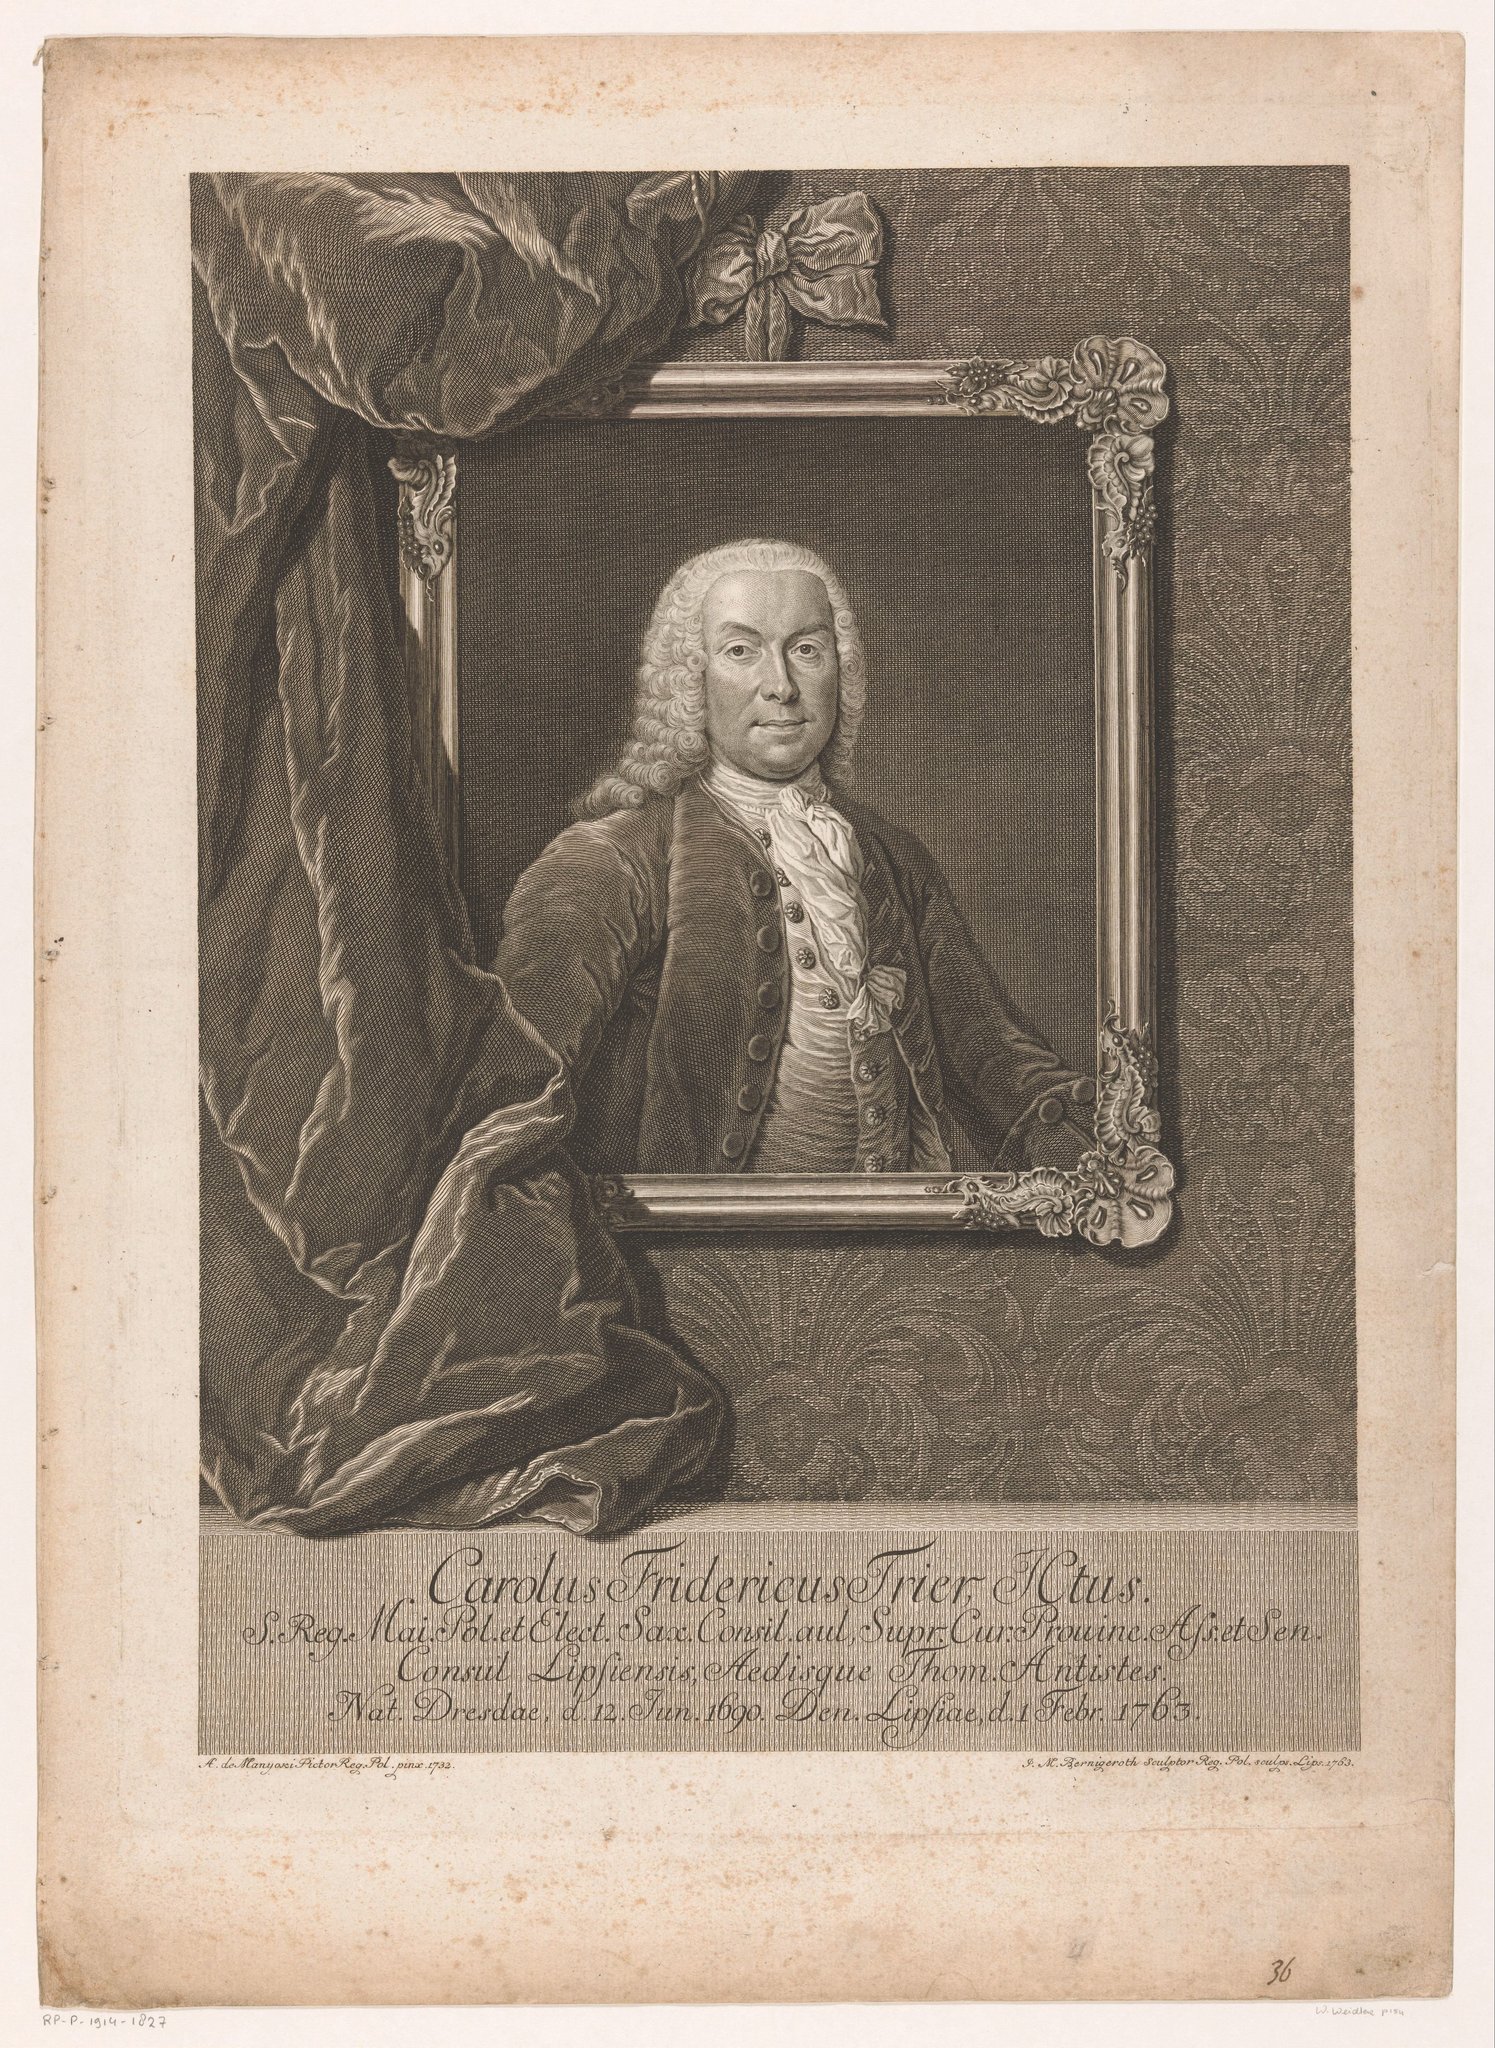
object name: print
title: Portret van Carl Friedrich Trier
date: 1763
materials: paper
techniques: engraving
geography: leipzig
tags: historical persons, picture, painting, frame of painting, etc.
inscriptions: collector's mark: Lugt 2228